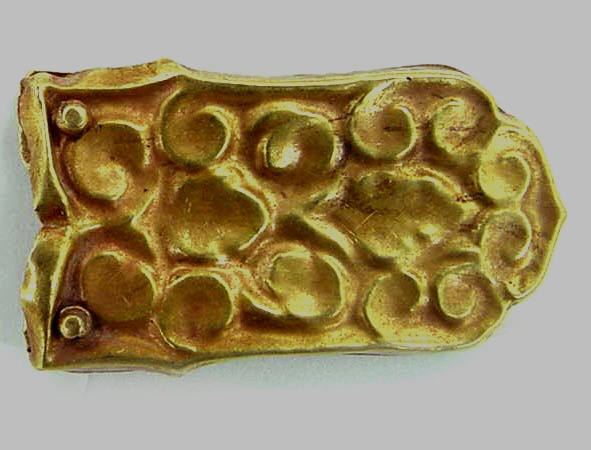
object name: belt fitting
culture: northwest chinese or eastern central asian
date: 634-900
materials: gold